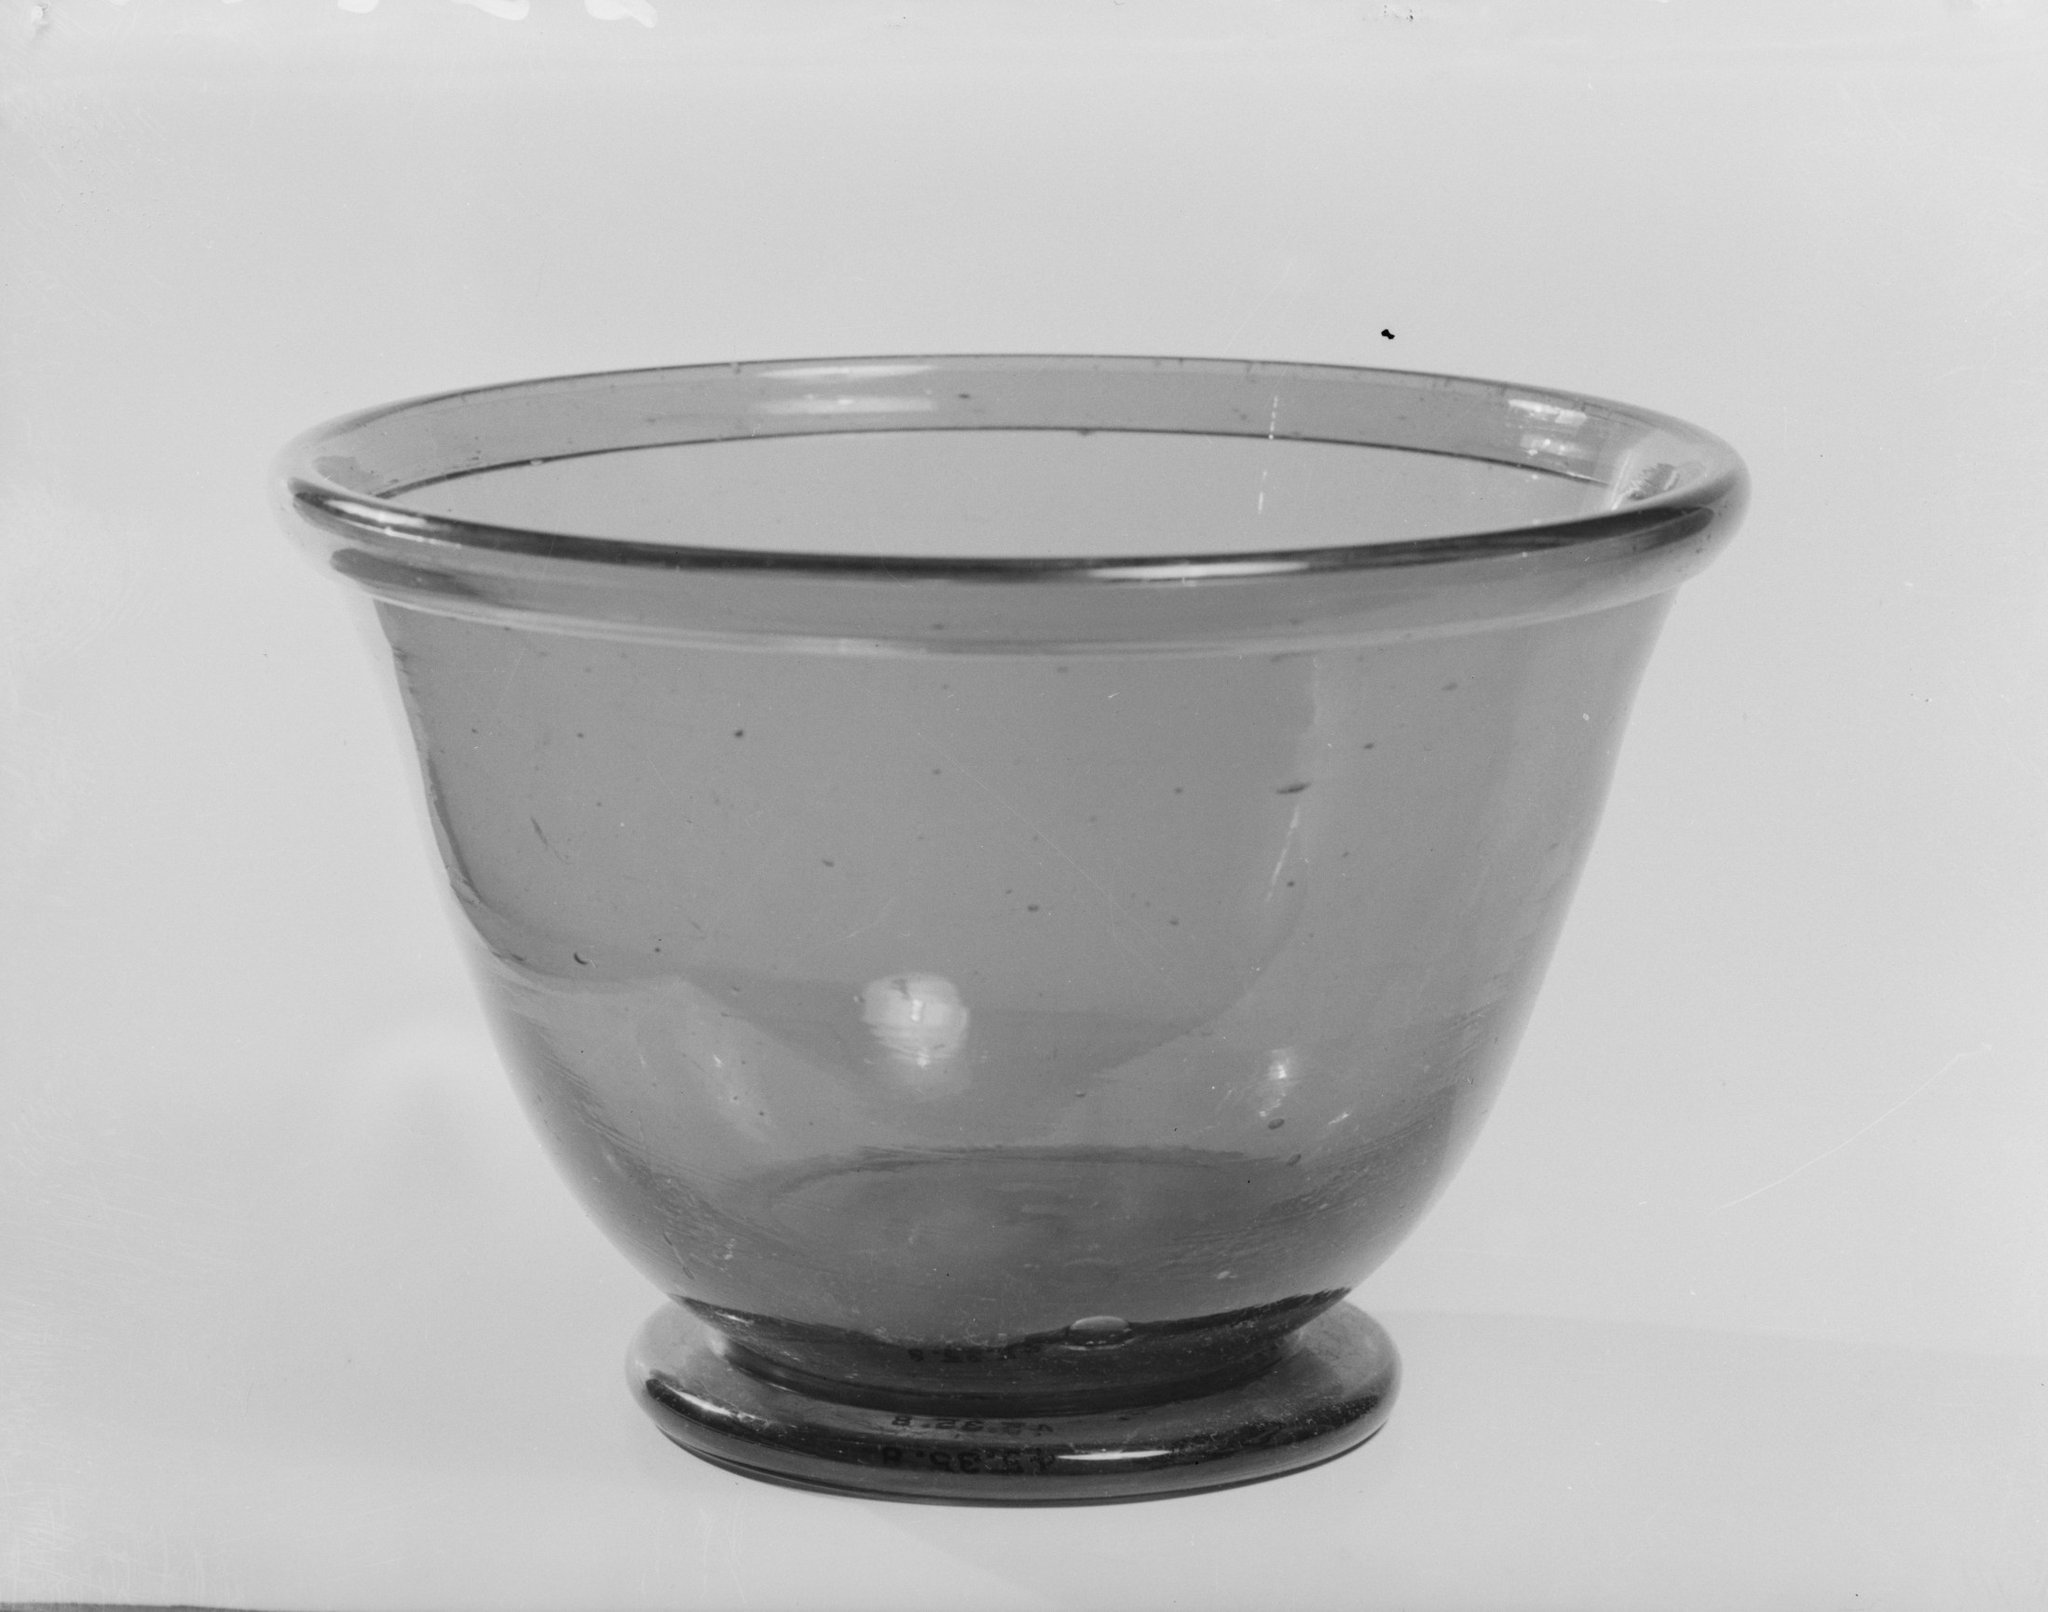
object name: bowl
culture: american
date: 1825-1850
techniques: glassblowing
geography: united states